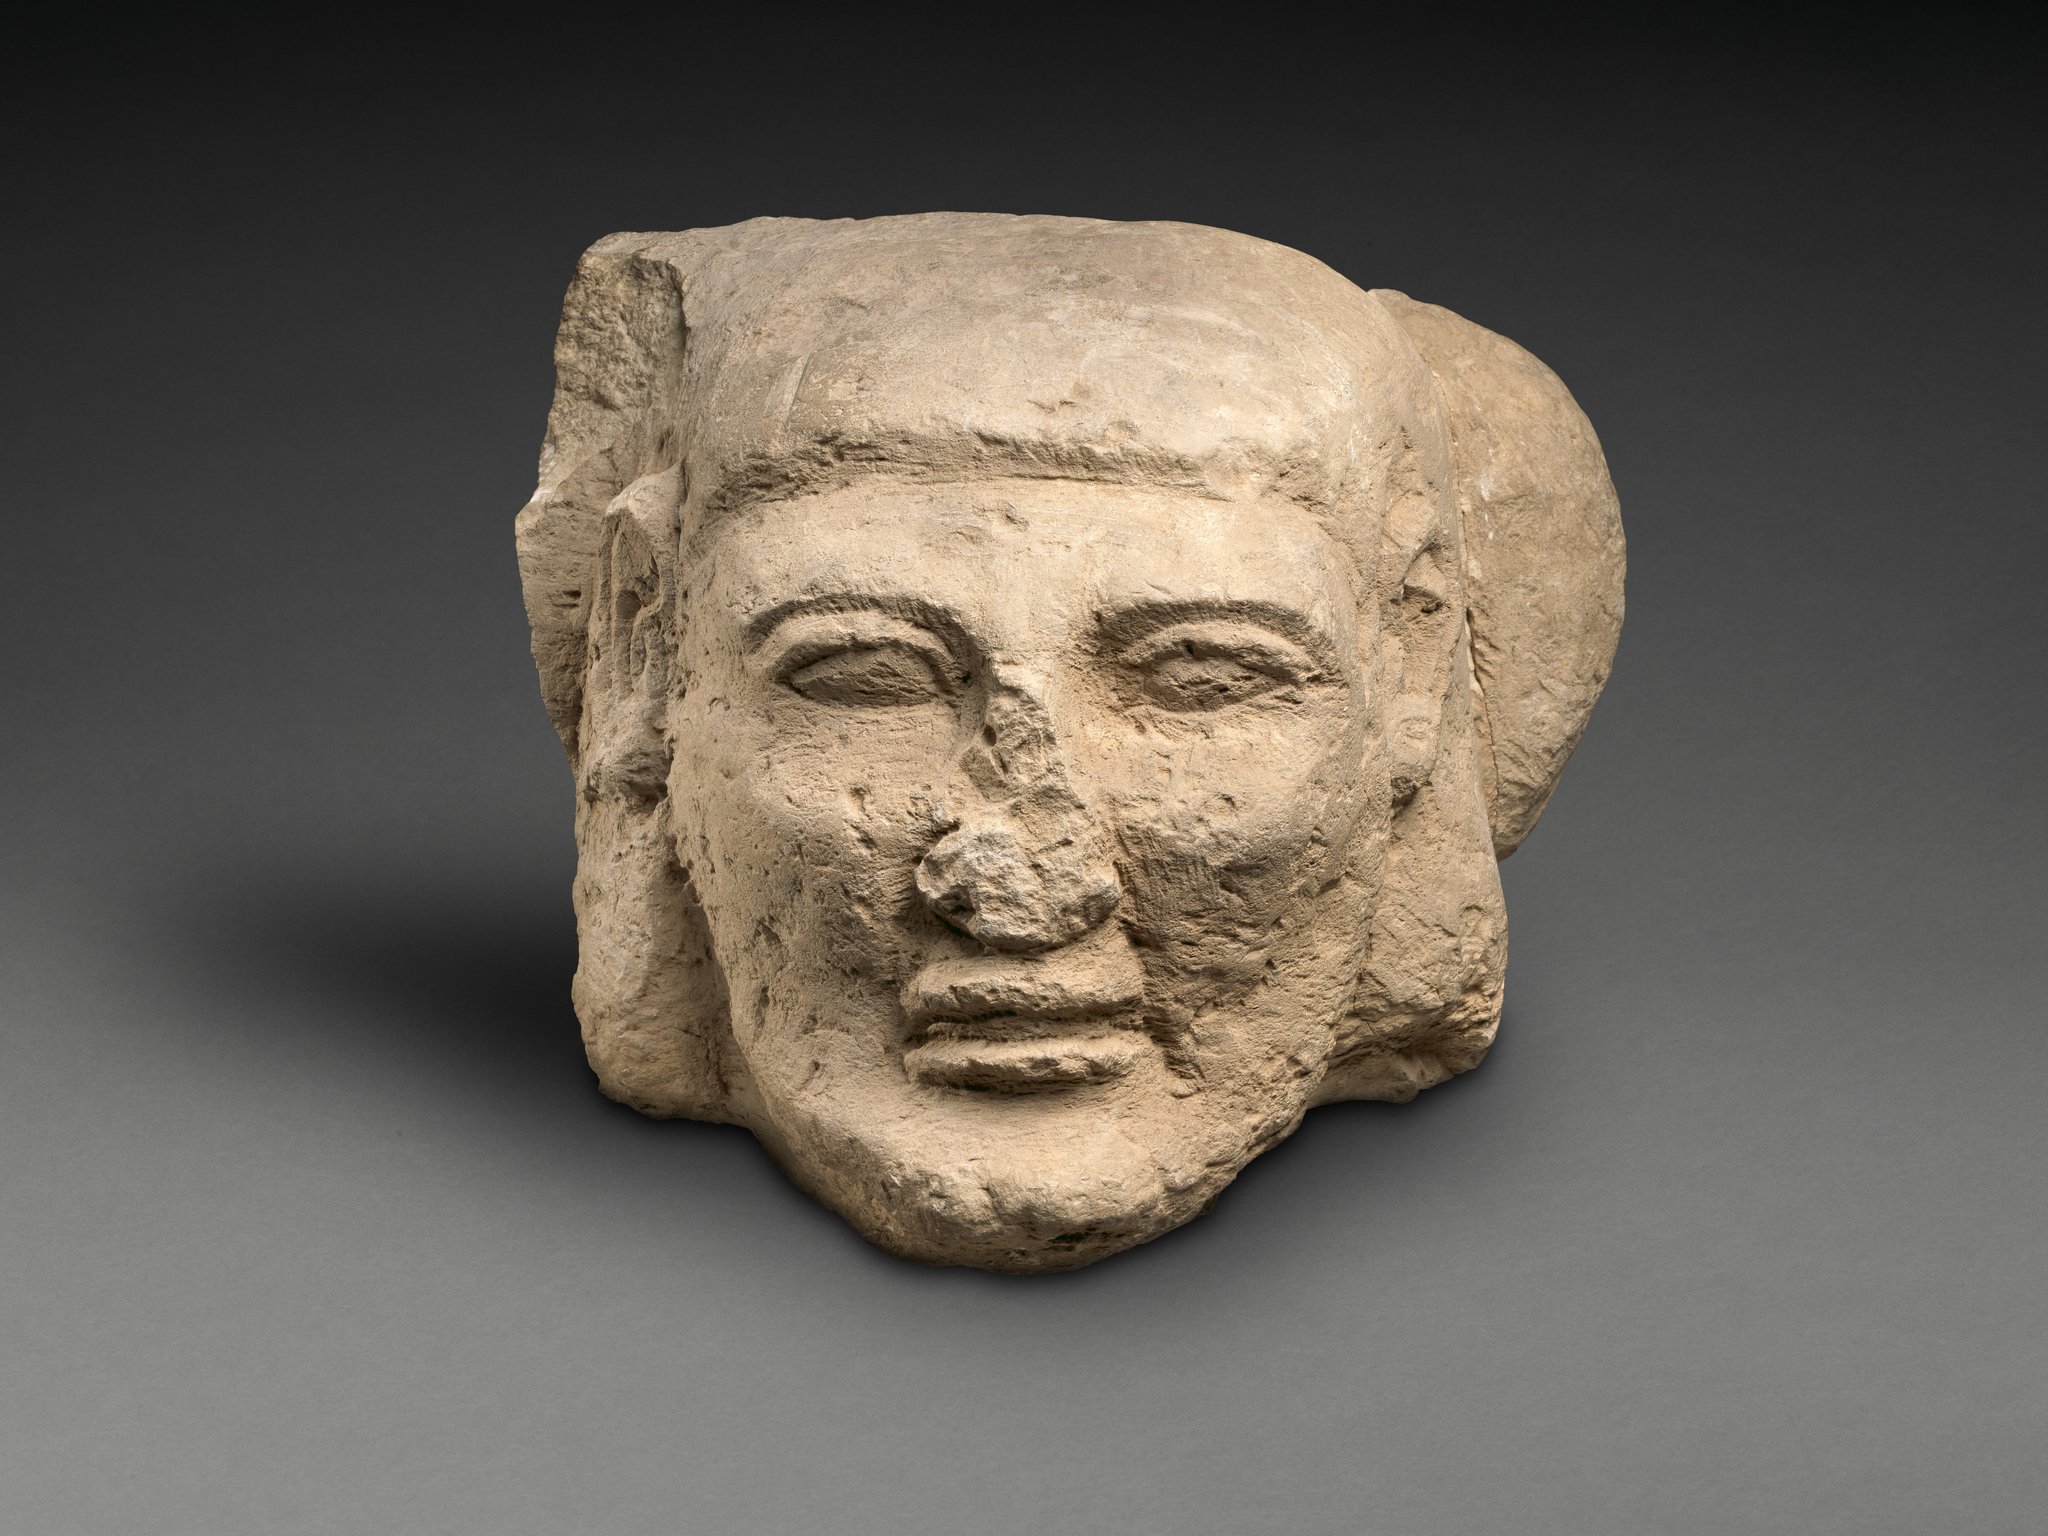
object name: head, captive, foreigner, asiatic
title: Monumental Head of a Foreigner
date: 1295-1070 BCE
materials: limestone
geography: egypt